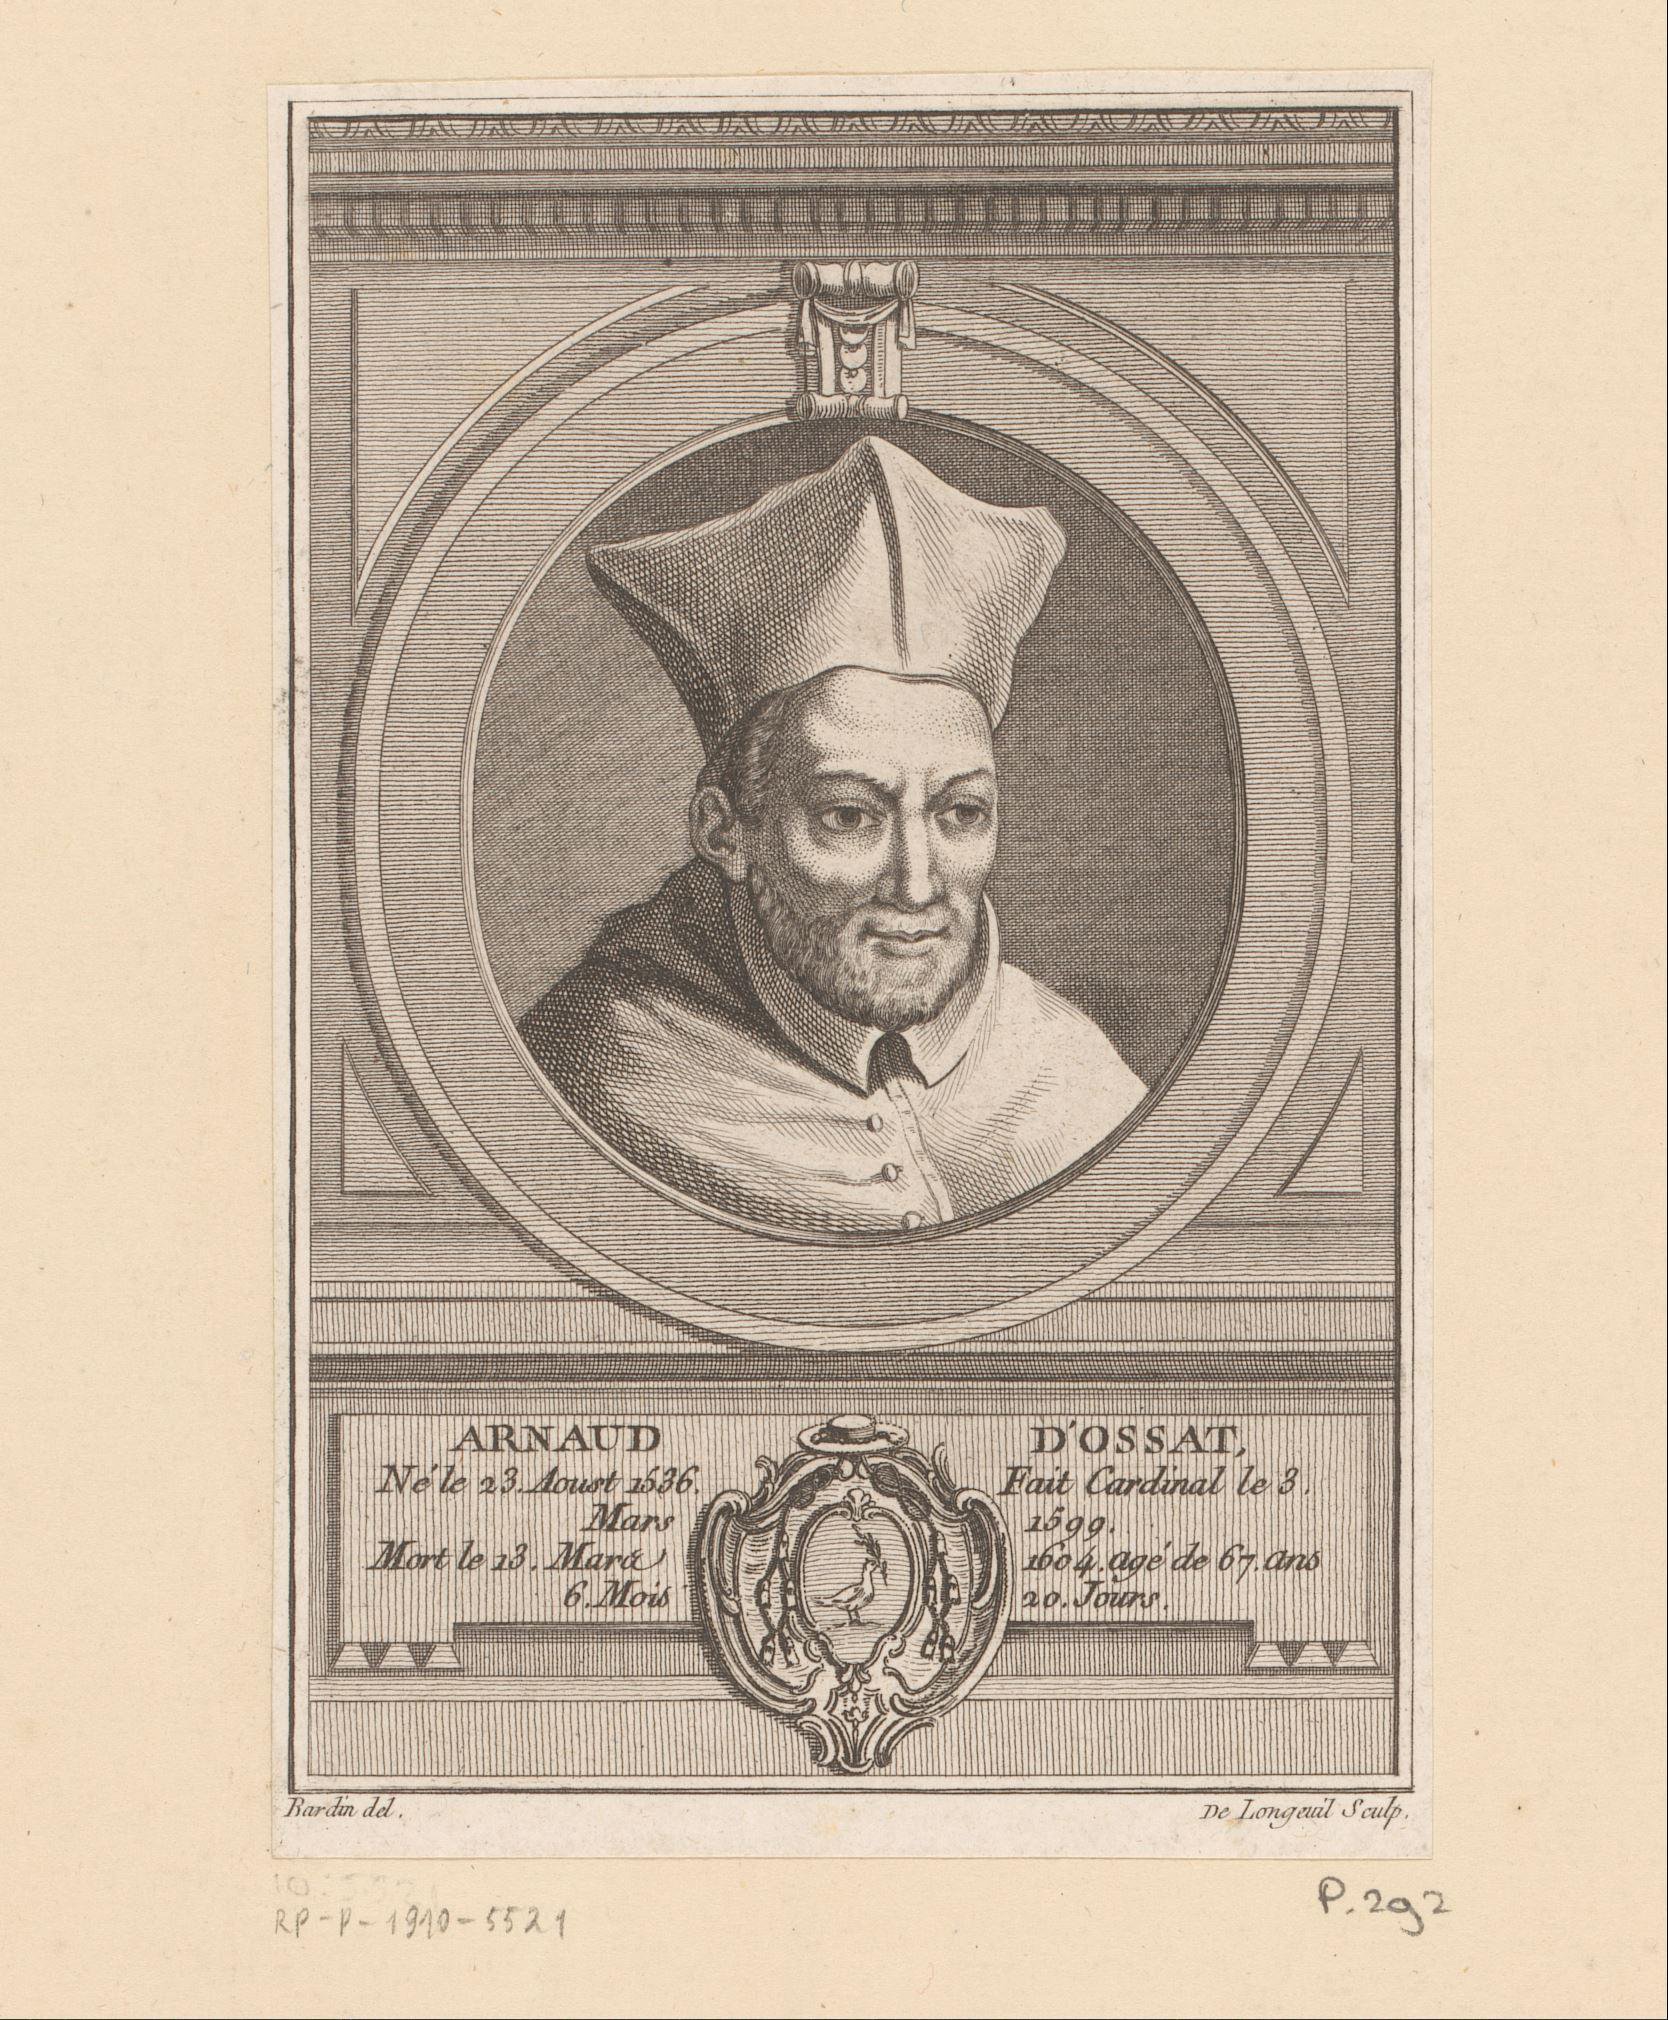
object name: print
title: Portret van Mesnard de la Noë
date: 1717-1757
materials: paper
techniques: engraving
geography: paris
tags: priest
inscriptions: collector's mark: Lugt 2228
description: Portret van Mesnard de la Noë, geestelijke en hoofd van het seminarie in Nantes.